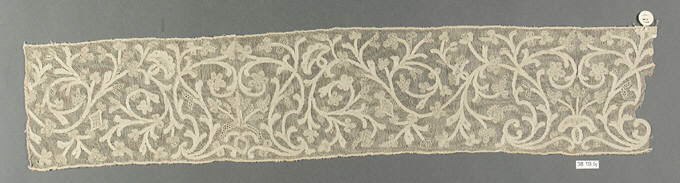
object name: hebrew ritual lace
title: Hebrew ritual lace (one of four)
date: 1701-1733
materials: silk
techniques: lace